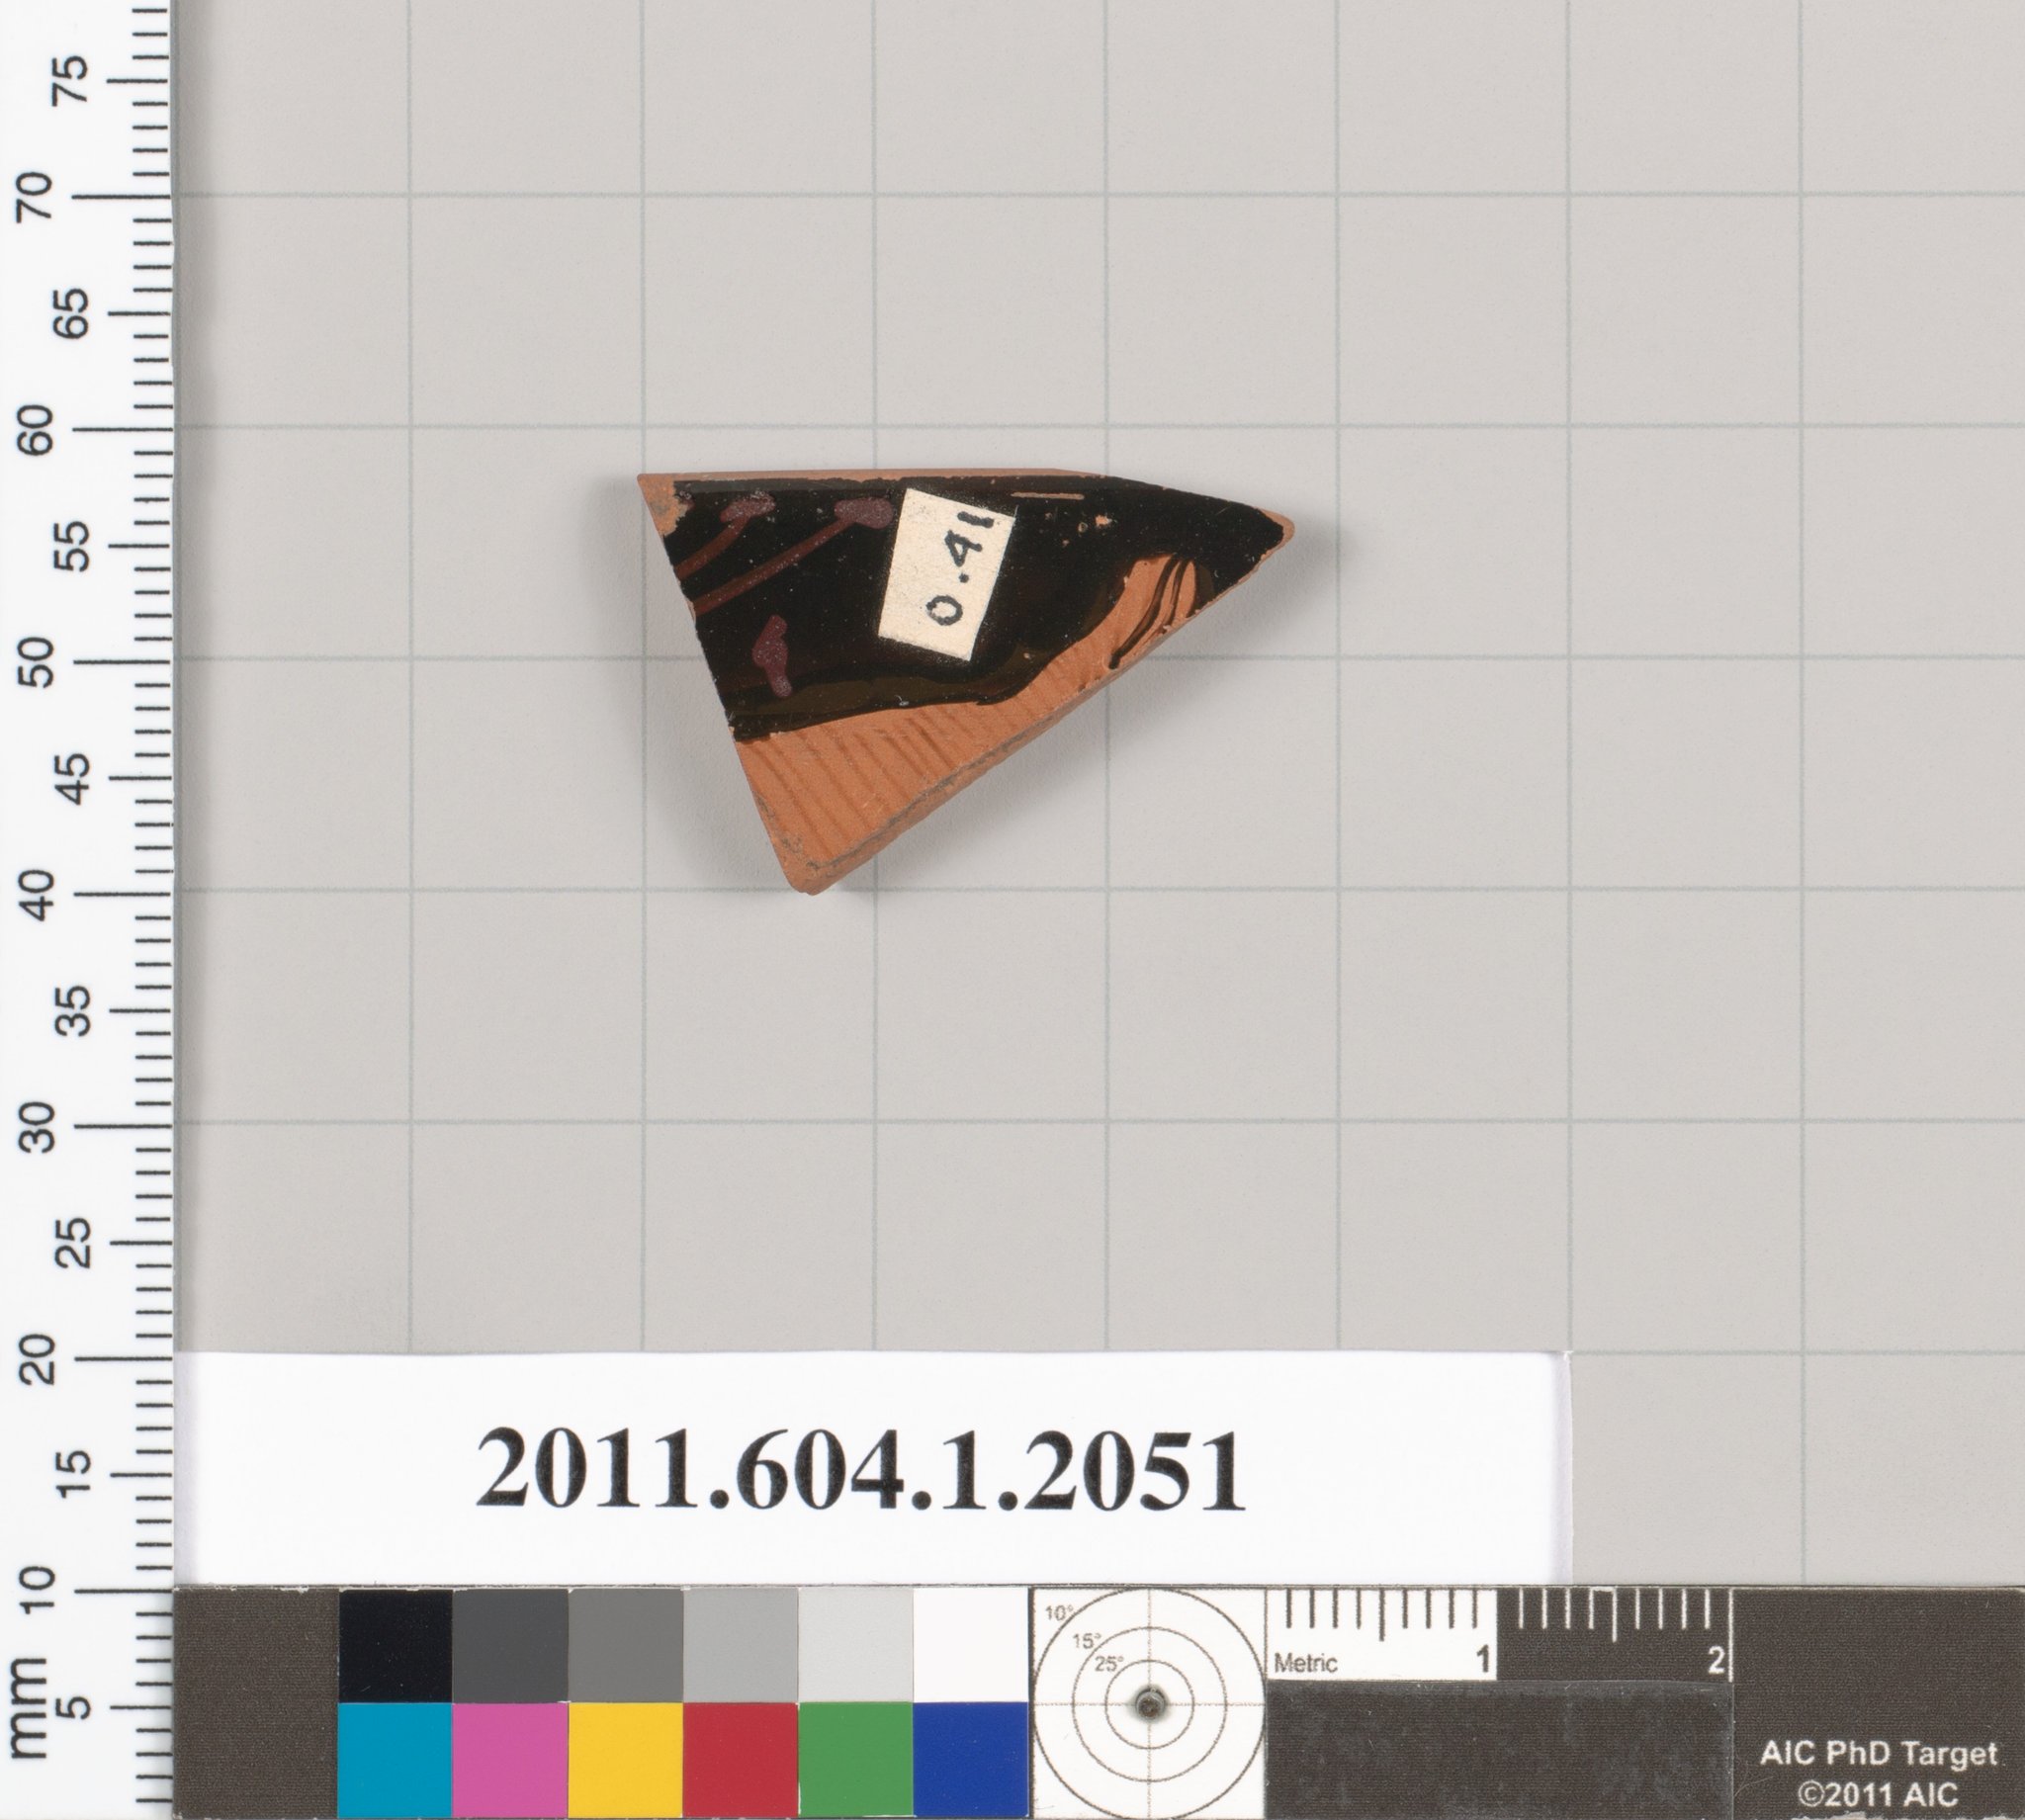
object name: kylix fragment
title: Terracotta rim fragment of a kylix (drinking cup)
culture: greek, attic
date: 475-451 BCE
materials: terracotta